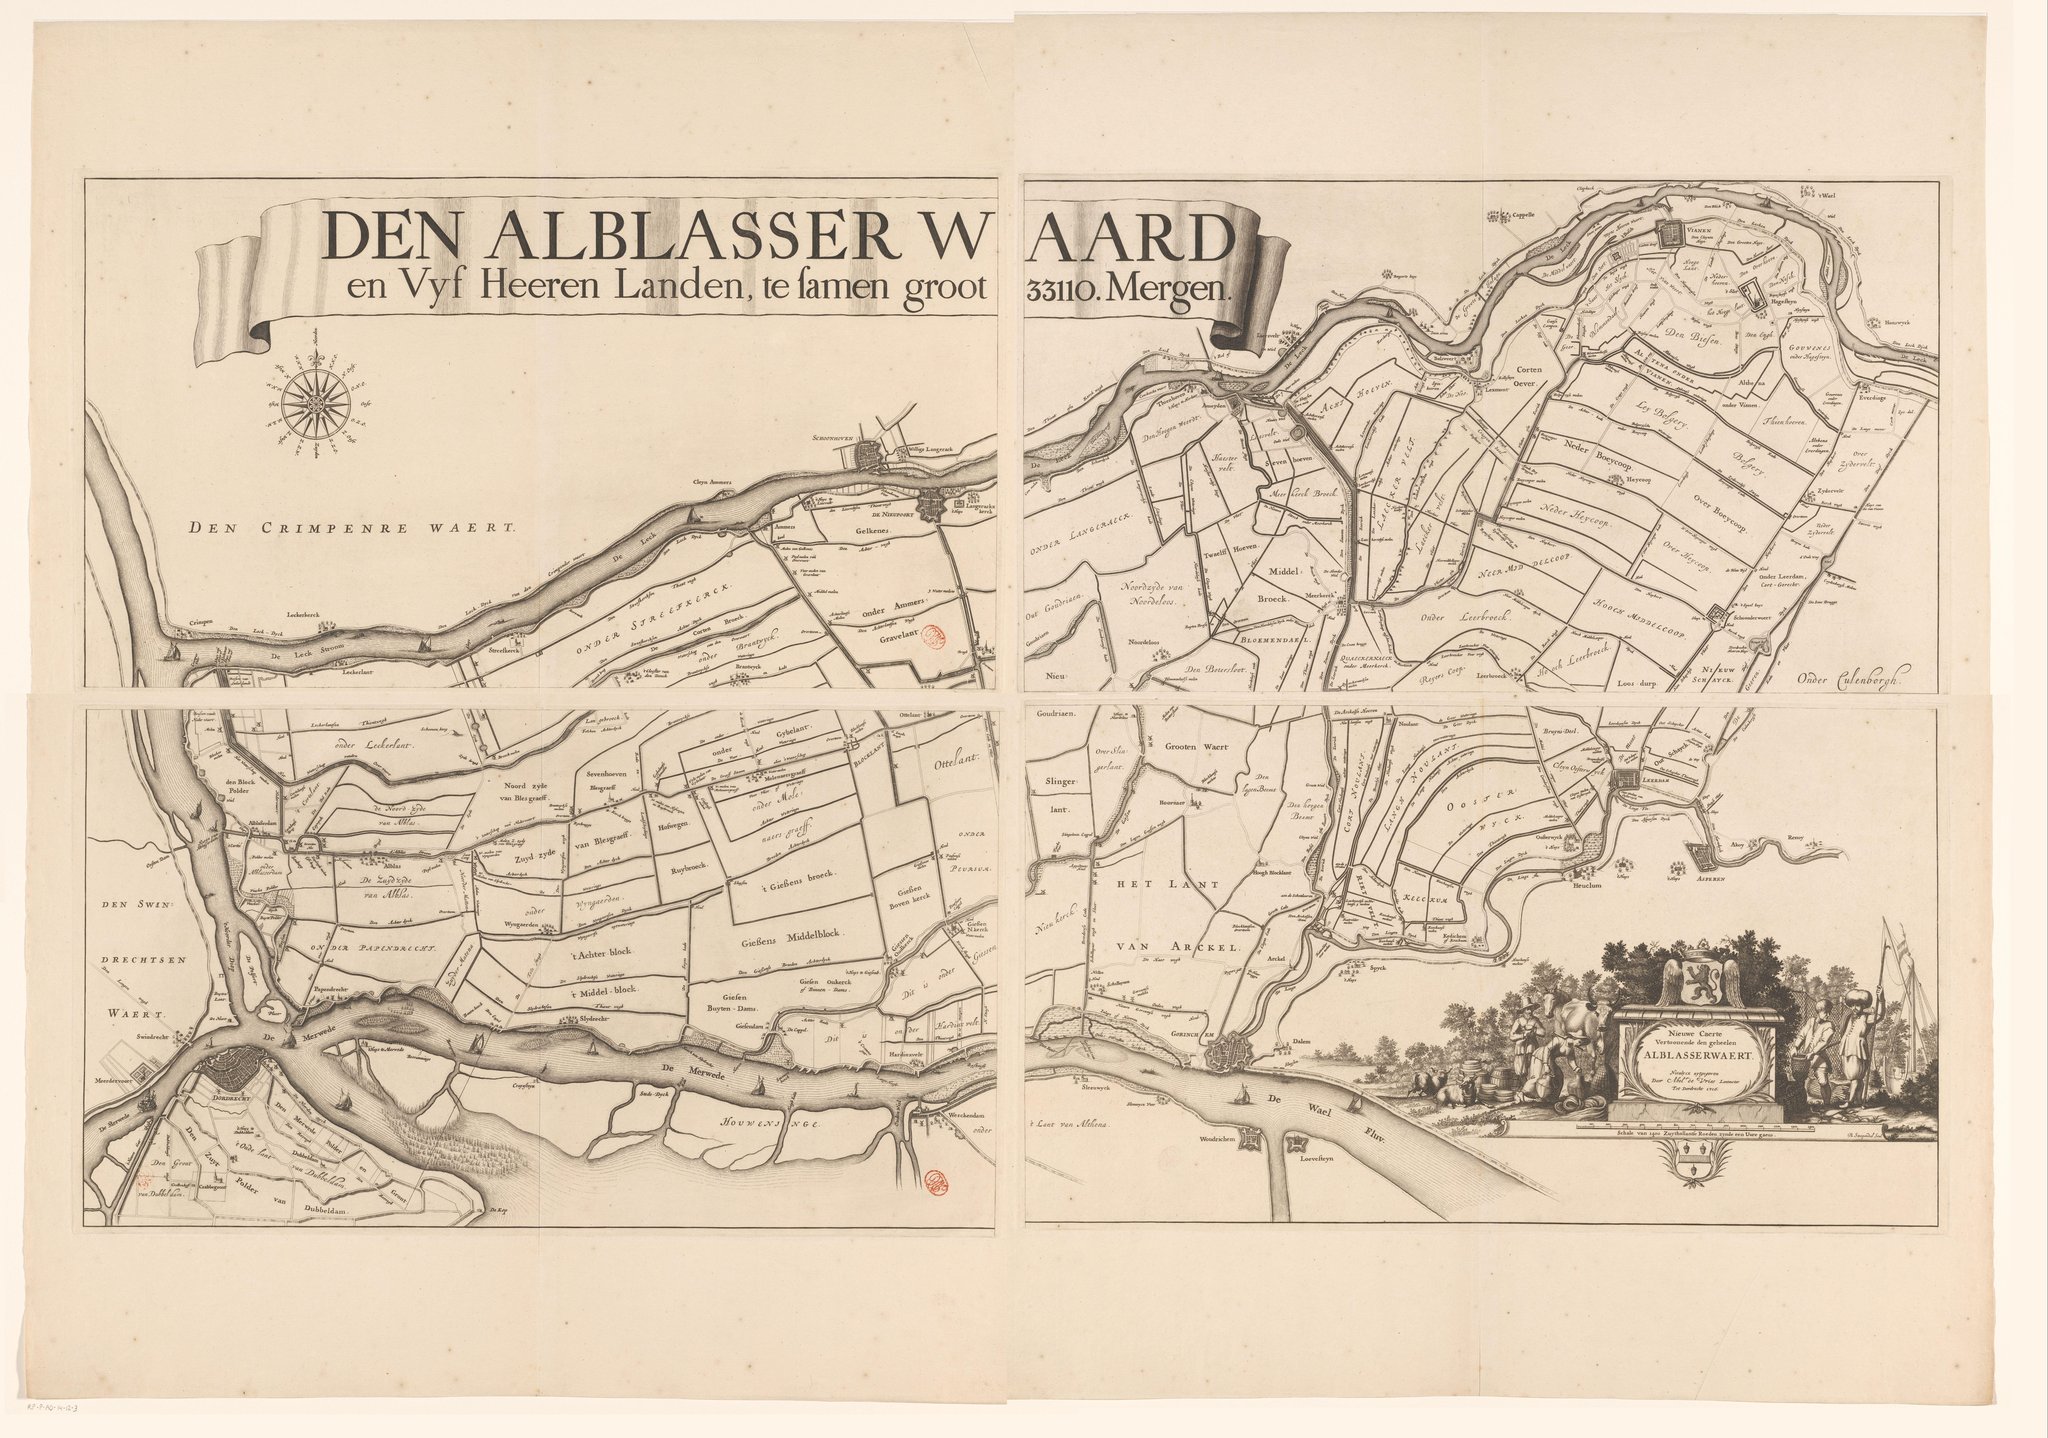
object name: map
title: Den Alblasser Waard en Vyf Heeren Landen, te samen groot 33110. mergen / Nieuwe caerte vertoonende den geheelen Alblasserwaert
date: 1681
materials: paper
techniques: engraving, etching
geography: dordrecht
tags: commercial fishery, coat of arms (as symbol of the state, etc.), sailing-ship, sailing-boat, maps of separate countries or regions, cattle, farmers, agriculture, polder, reclaimed land, milkmaid, fisherman, cheese, armorial bearing, heraldry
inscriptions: collector's mark: Lugt 195, collector's mark: Lugt 195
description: Langs de bovenkant een banderol met de eerste titel. Rechtsonder een cartouche met de tweede titel en daarboven het wapen van de Alblasserwaard. Links van de cartouche een landbouwer, een vrouwfiguur met een melkjuk, vee en voorwerpen die verwijzen naar de landbouw. Rechts van de cartouche een visser met een visnet, een visser met een enterhaak, een vissersboot en andere voorwerpen die verwijzen naar de visserij. Onder de cartouche een schaalstok: Schale van 1400 Zuythollantse roeden, zynde een uure gaens. Daaronder een wapenschild met drie eikels en een dwarsbalk (vermoedelijk het wapen van landmeter Abel de Vries).